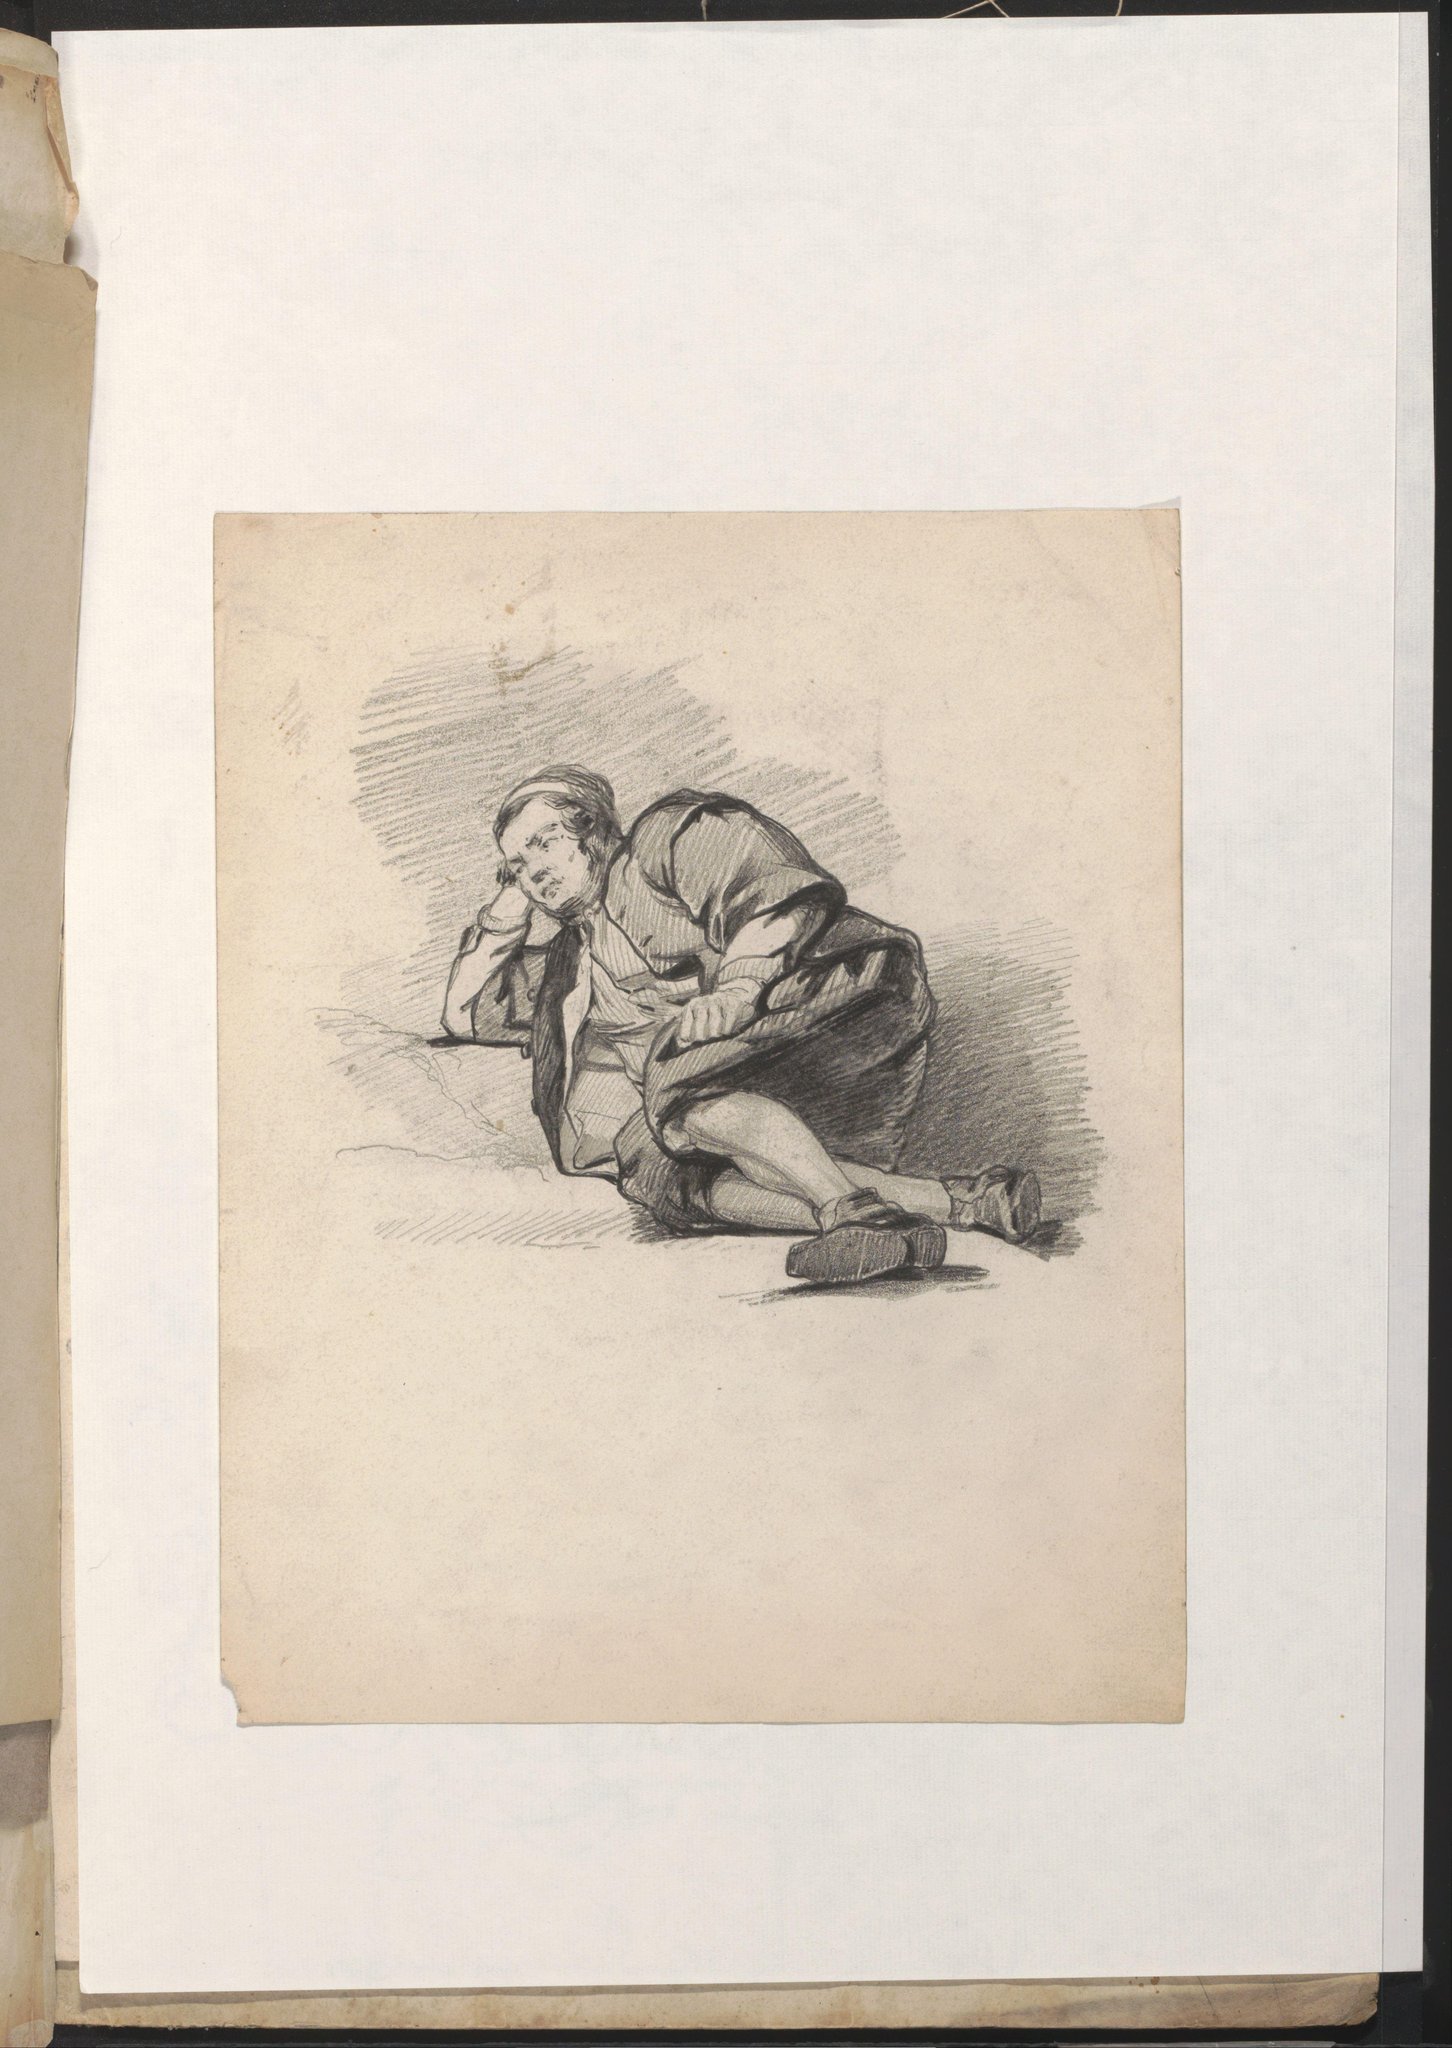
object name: sketchbook leaf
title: Liggende man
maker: johannes huybertus van hove bzn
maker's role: print maker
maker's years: 1827-1881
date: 1837-1881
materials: paper, pencil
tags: lying on one side, with uplifted upper part of the body and leaning on the arm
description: Blad 41 recto, los blad in een schetsboek met 33 bladen en 10 losse tekeningen.